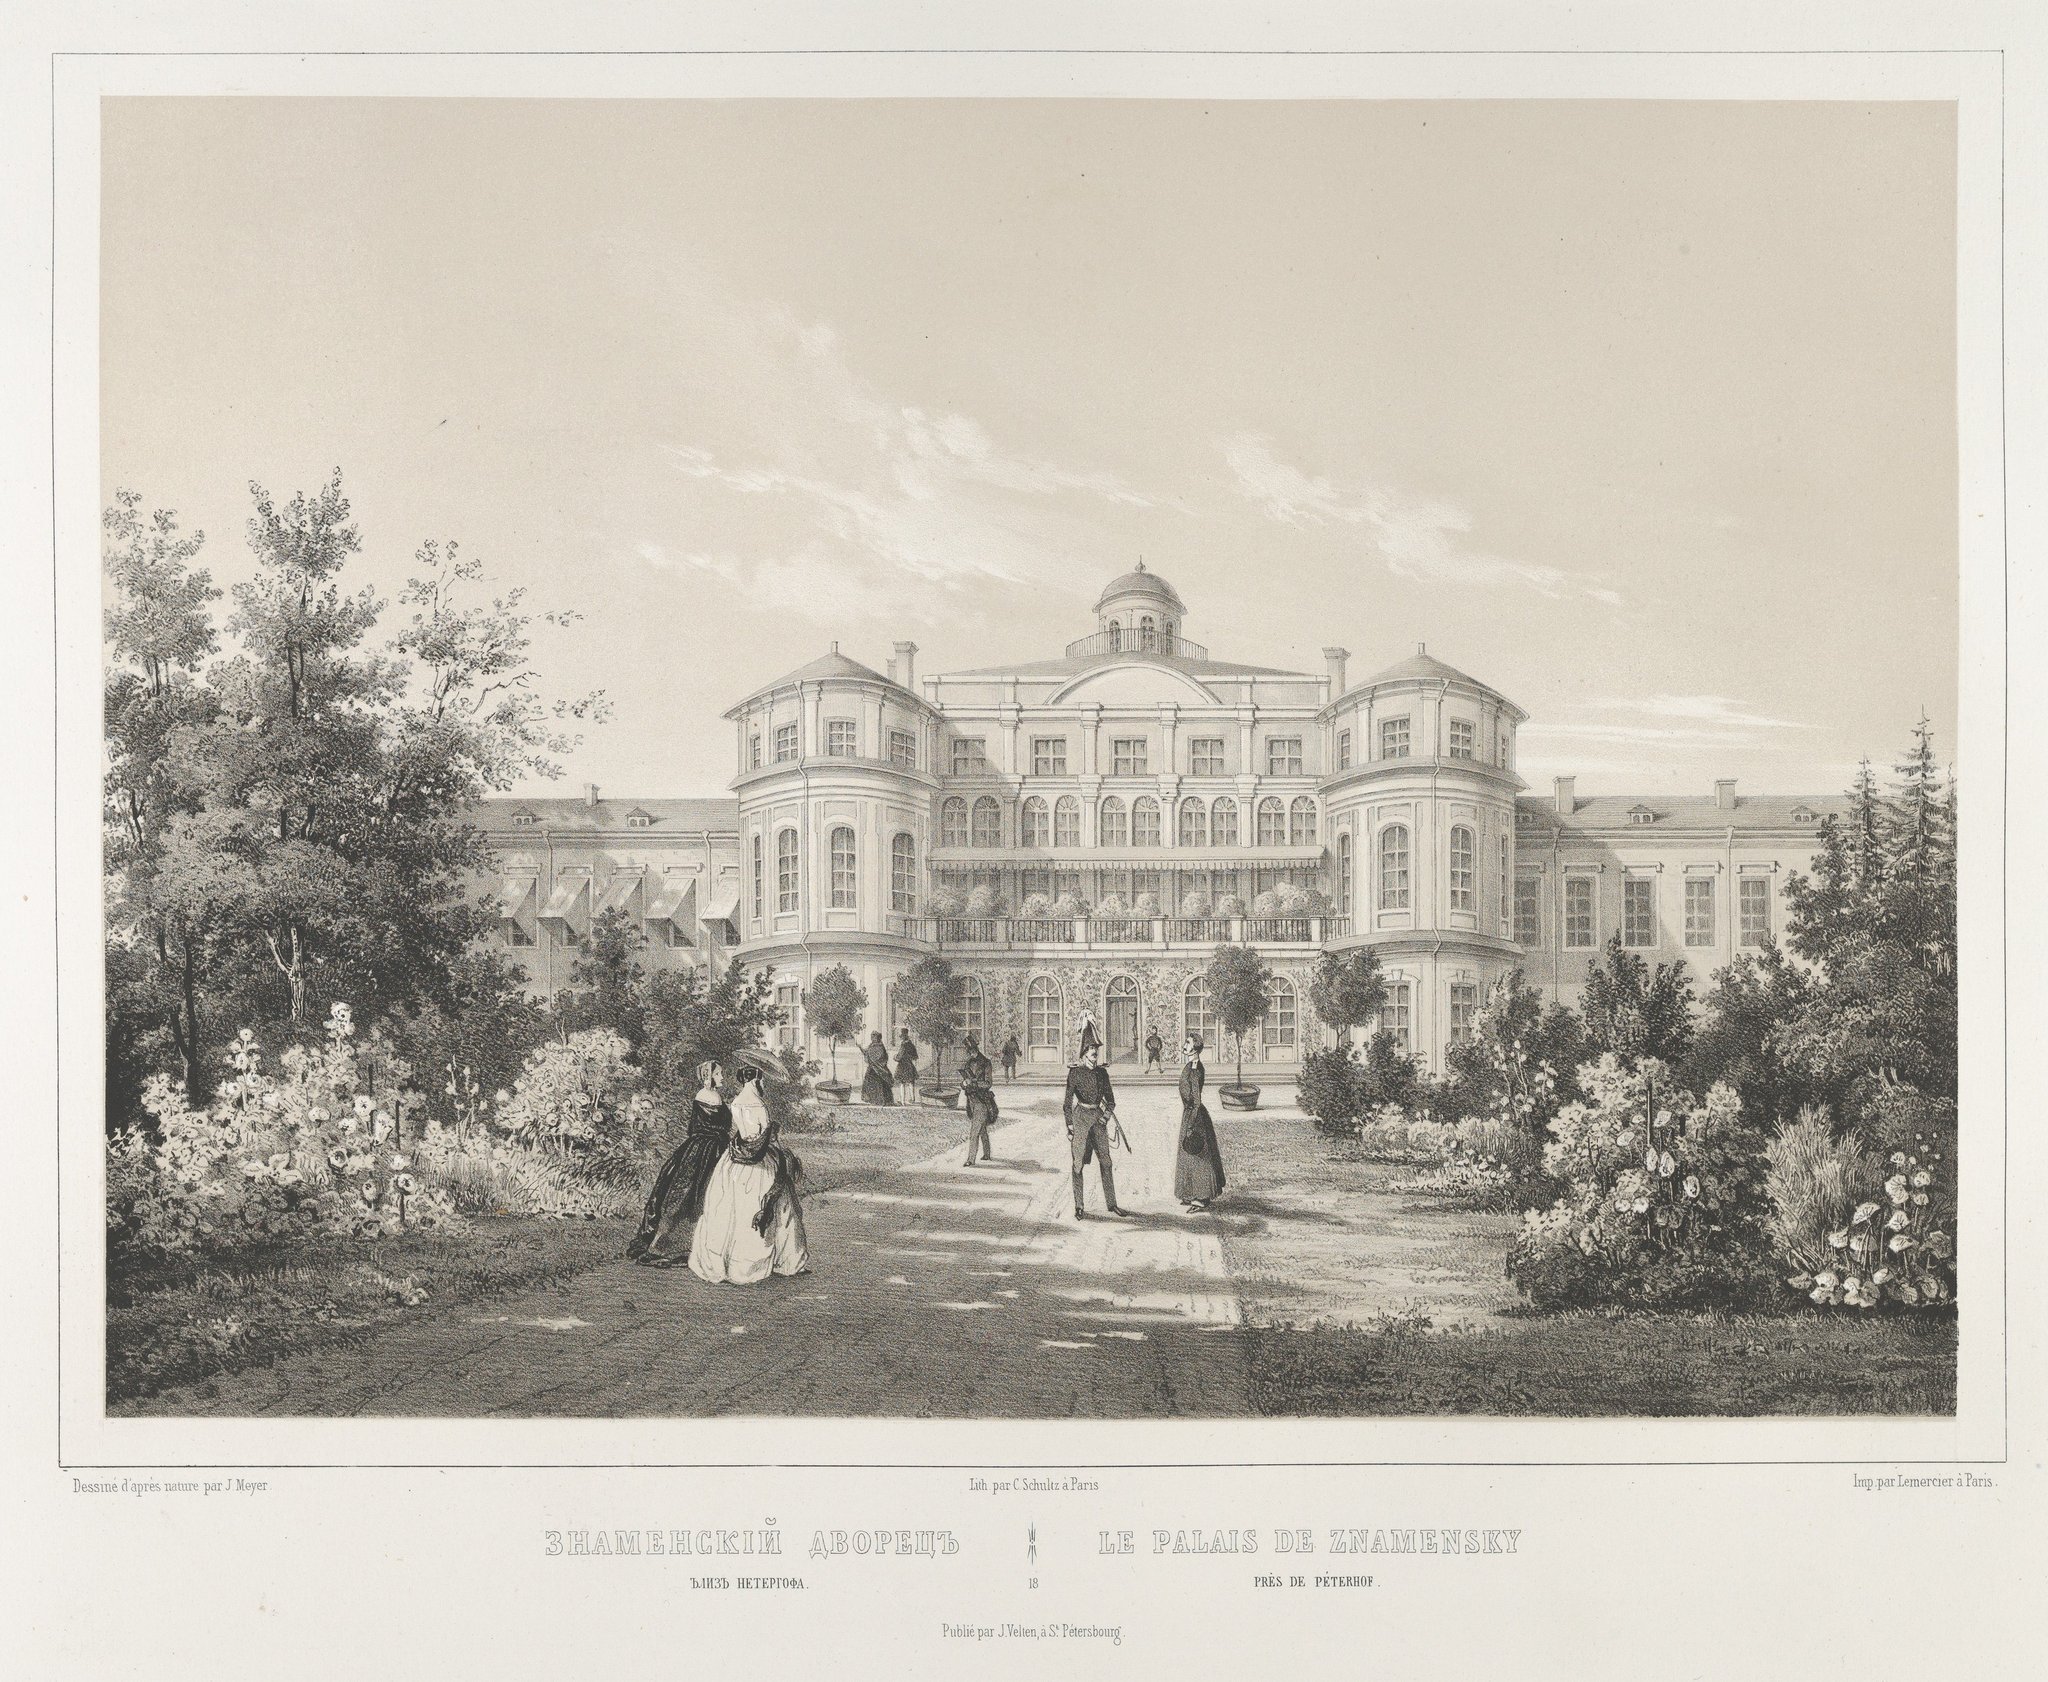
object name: print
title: Le Palais de Znamensky près de Peterhof, from "Vues pittoresques des palais & jardins impériaux aux environs de St. Petersbourg"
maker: j. meyer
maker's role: artist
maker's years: 1800-1900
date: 1850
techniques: lithograph, printing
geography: russia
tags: palaces,gardens,men,women,trees